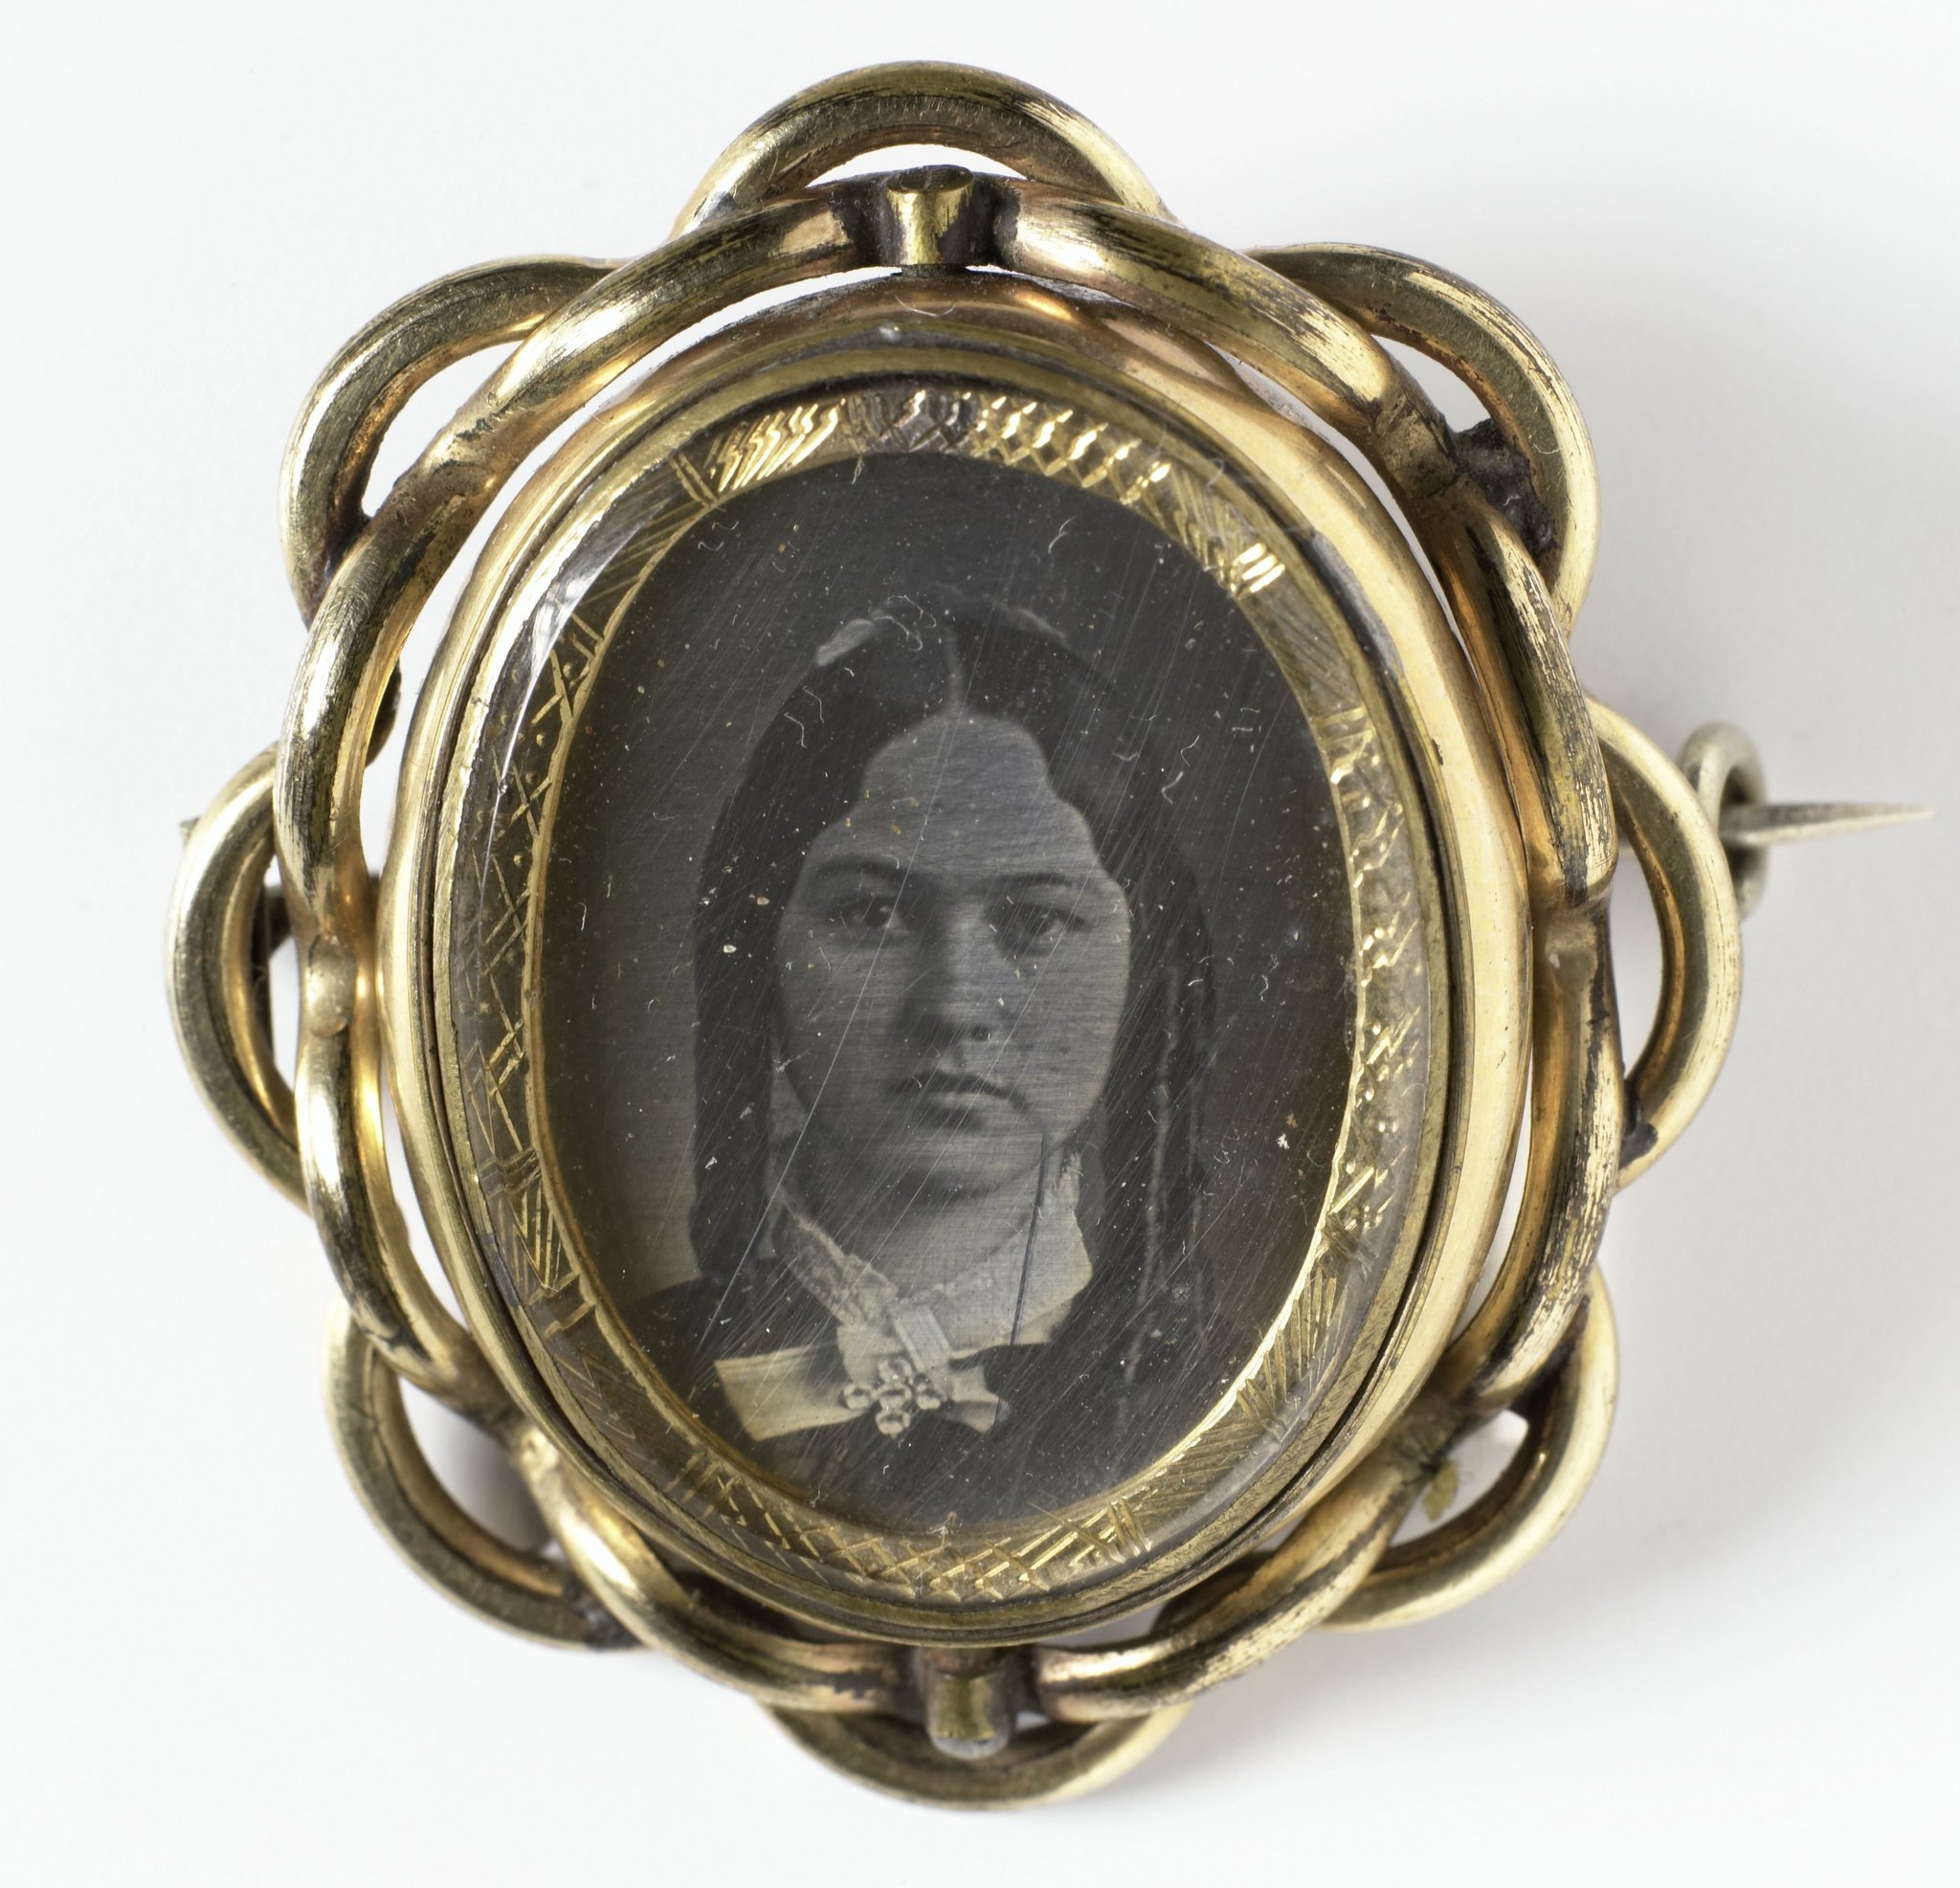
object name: brooch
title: Portret van een onbekende jonge vrouw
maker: Anonymous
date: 1840-1860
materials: copper, glass, metal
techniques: daguerreotype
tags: adolescent, young woman, maiden, historical persons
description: Samen met RP-F-F14349-B in een broche welke gekanteld kan worden om andere foto te tonen.